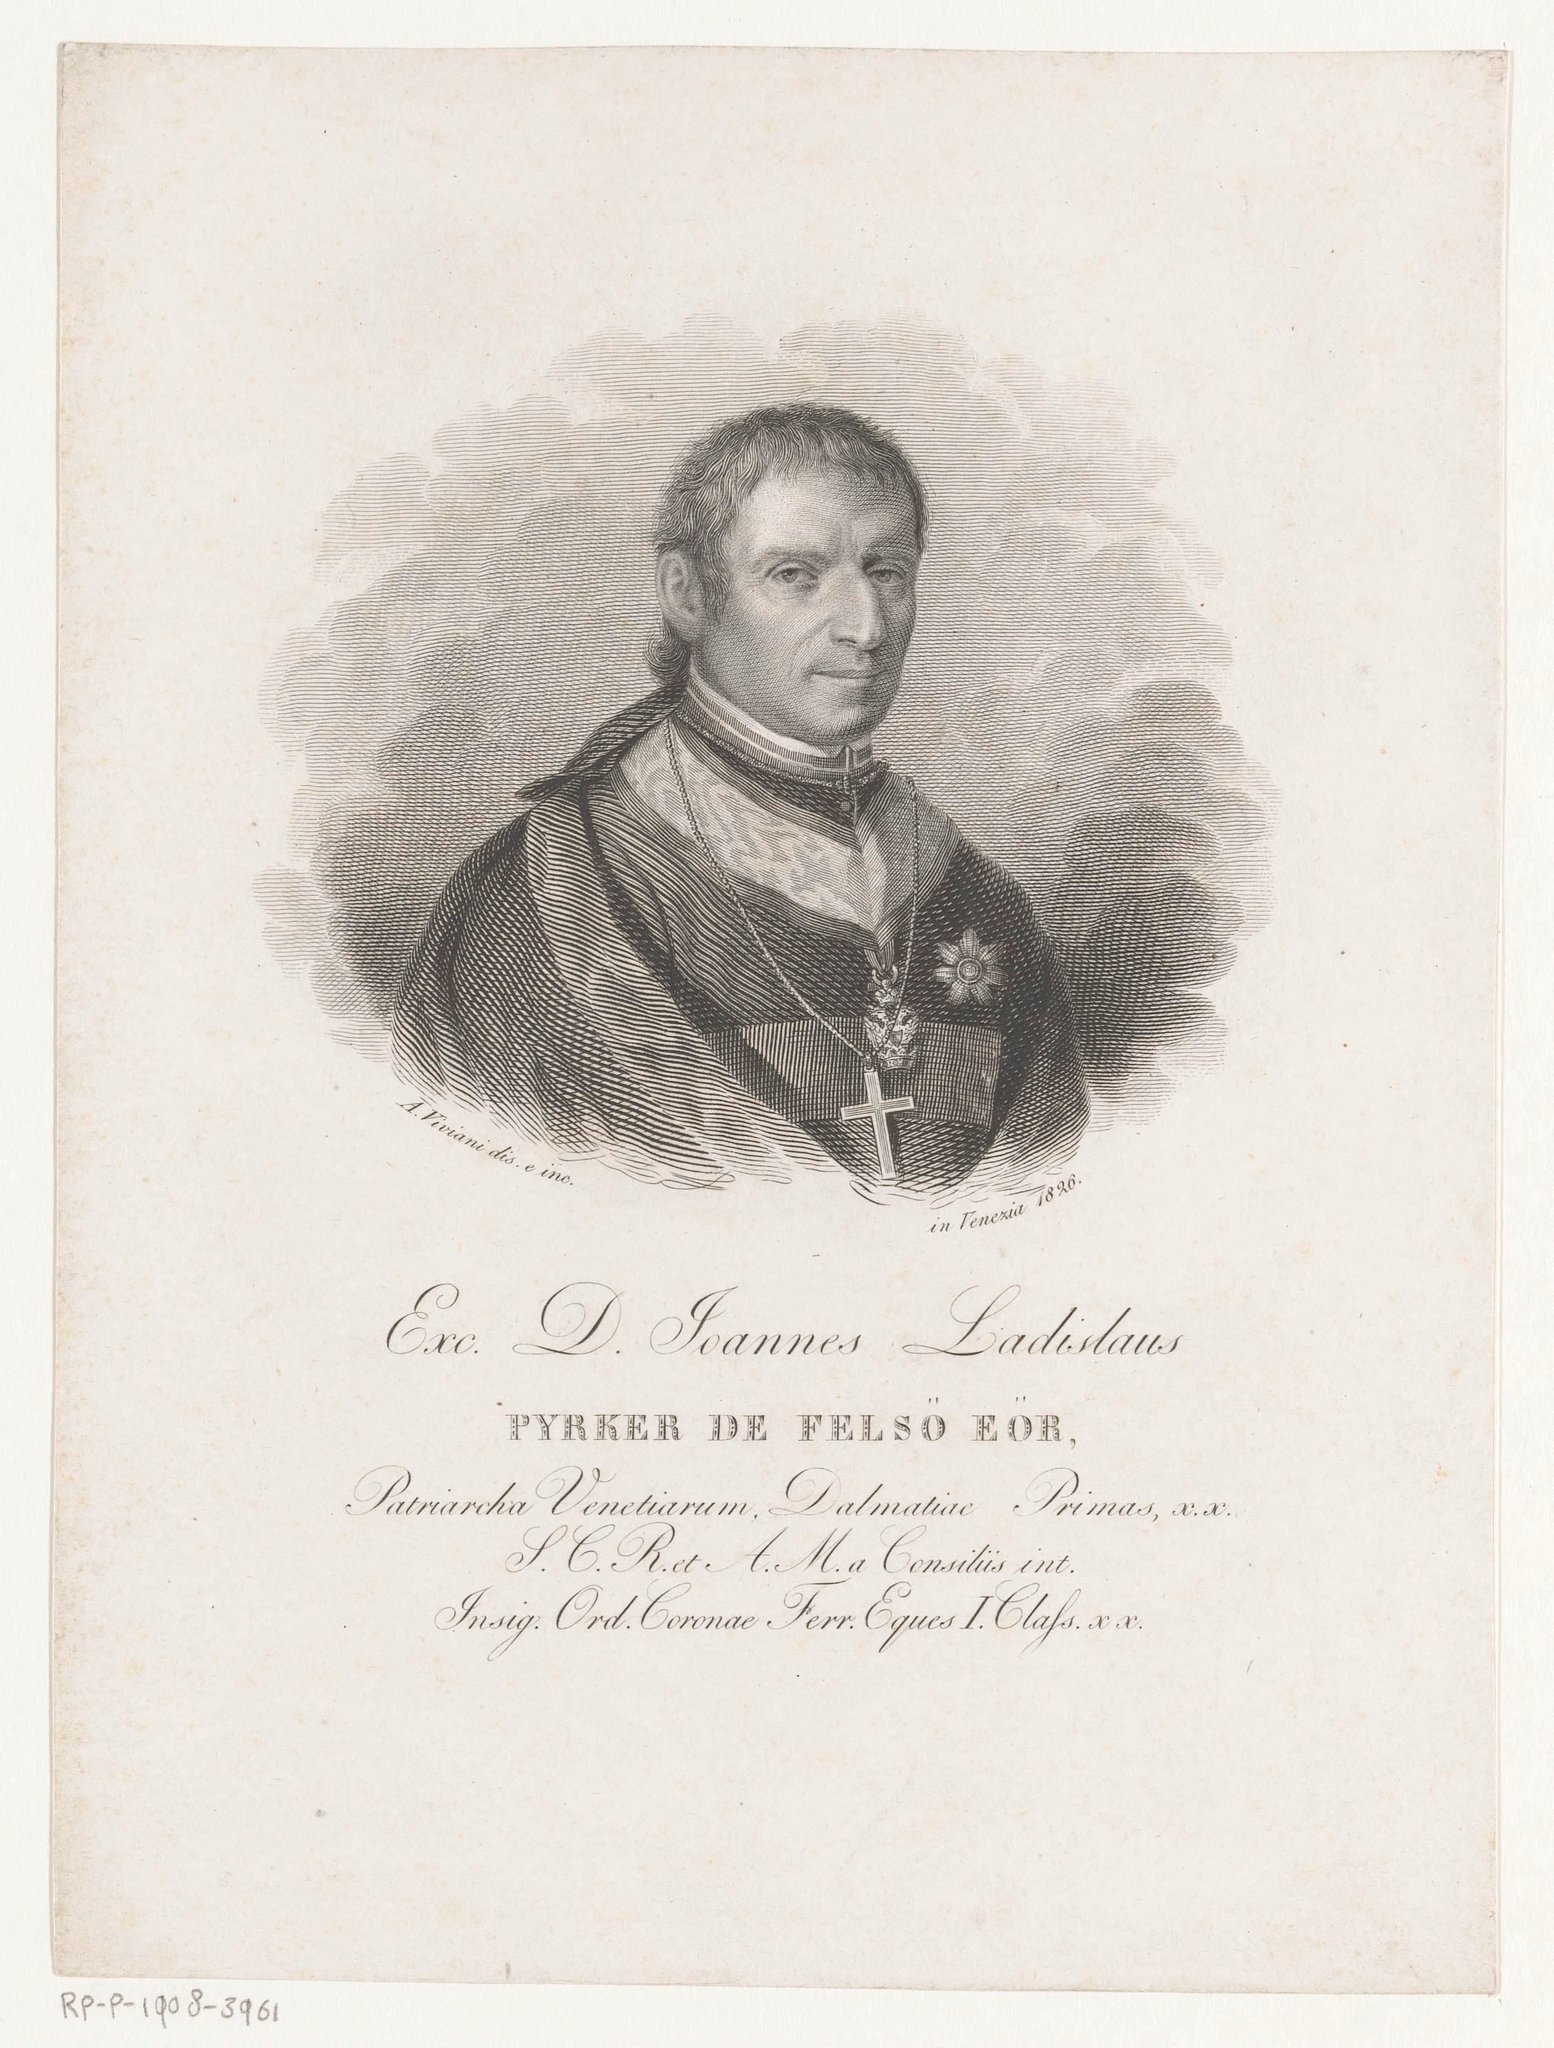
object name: print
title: Portret van abt Ladislaus Pyrker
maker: antonio viviani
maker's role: draughtsman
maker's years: 1560-1620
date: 1826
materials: paper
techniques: engraving, etching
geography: venice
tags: vienna, historical persons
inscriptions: collector's mark: Lugt 2228